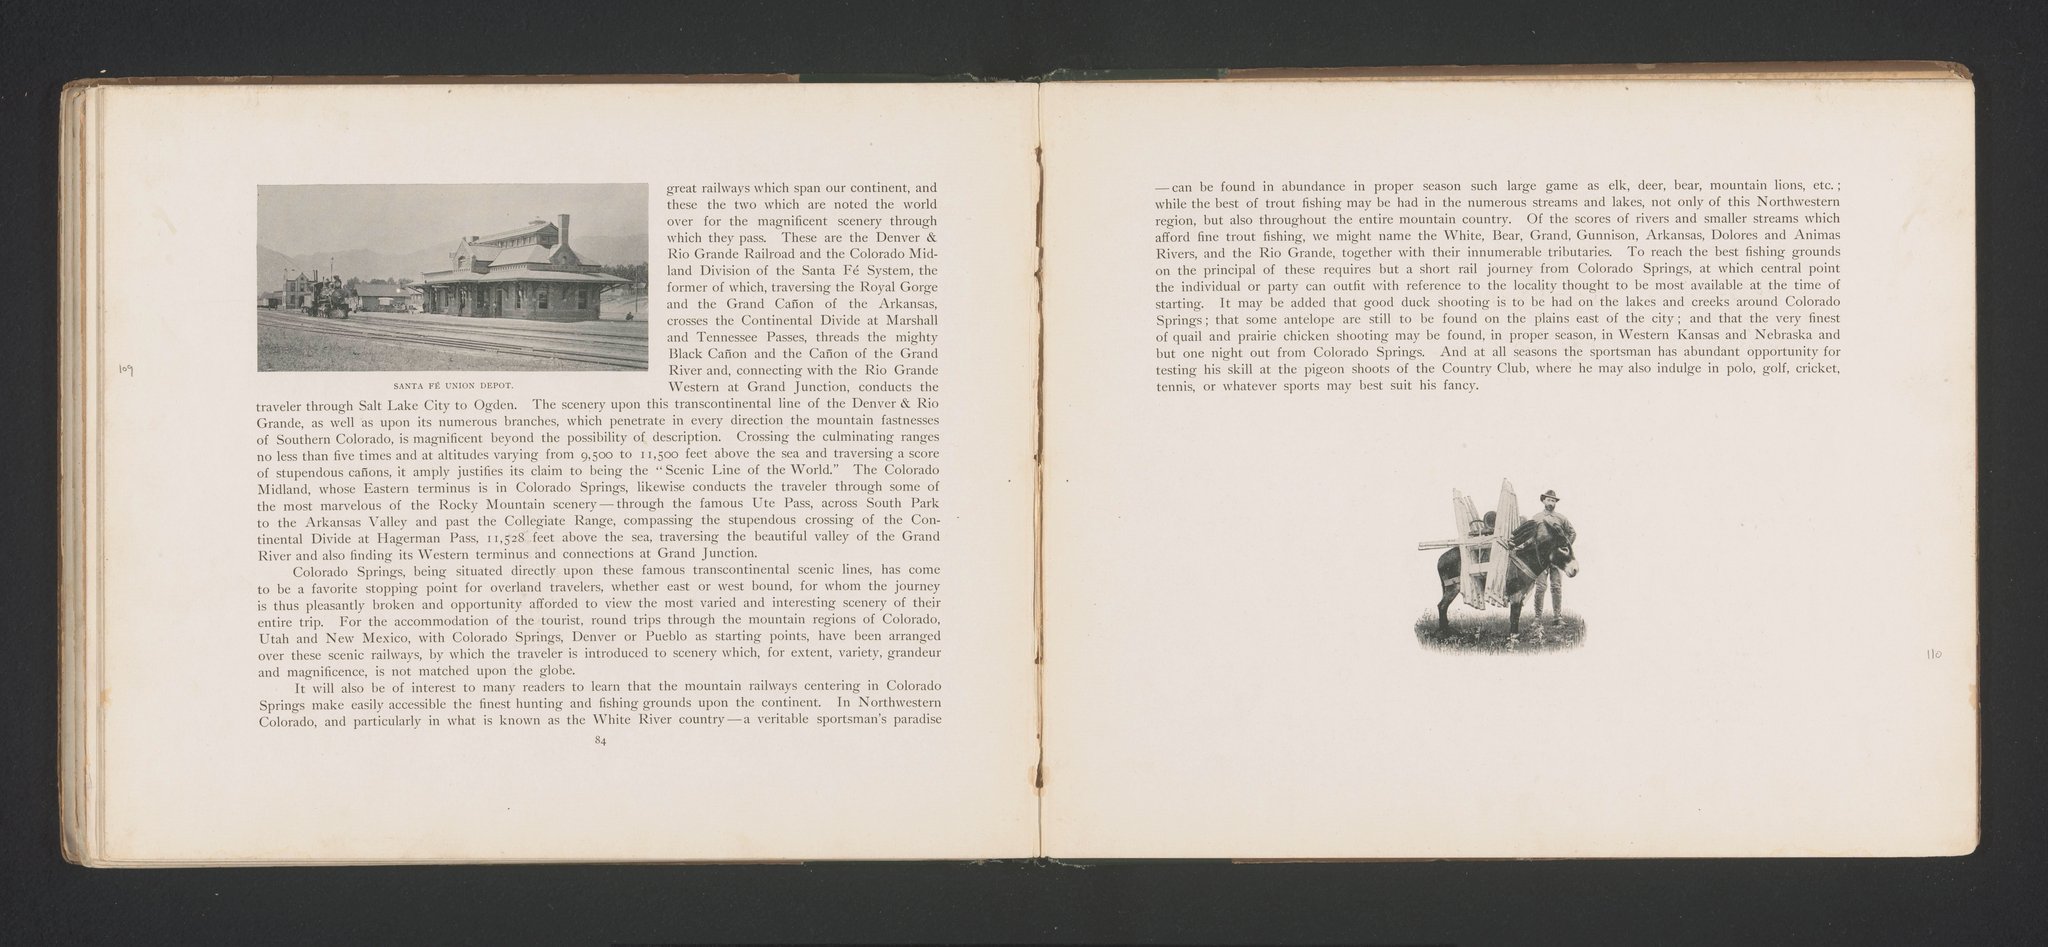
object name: photomechanical print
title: Man met een pakezel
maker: Anonymous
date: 1888-1893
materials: paper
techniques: autotype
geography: colorado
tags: ass, donkey, mule